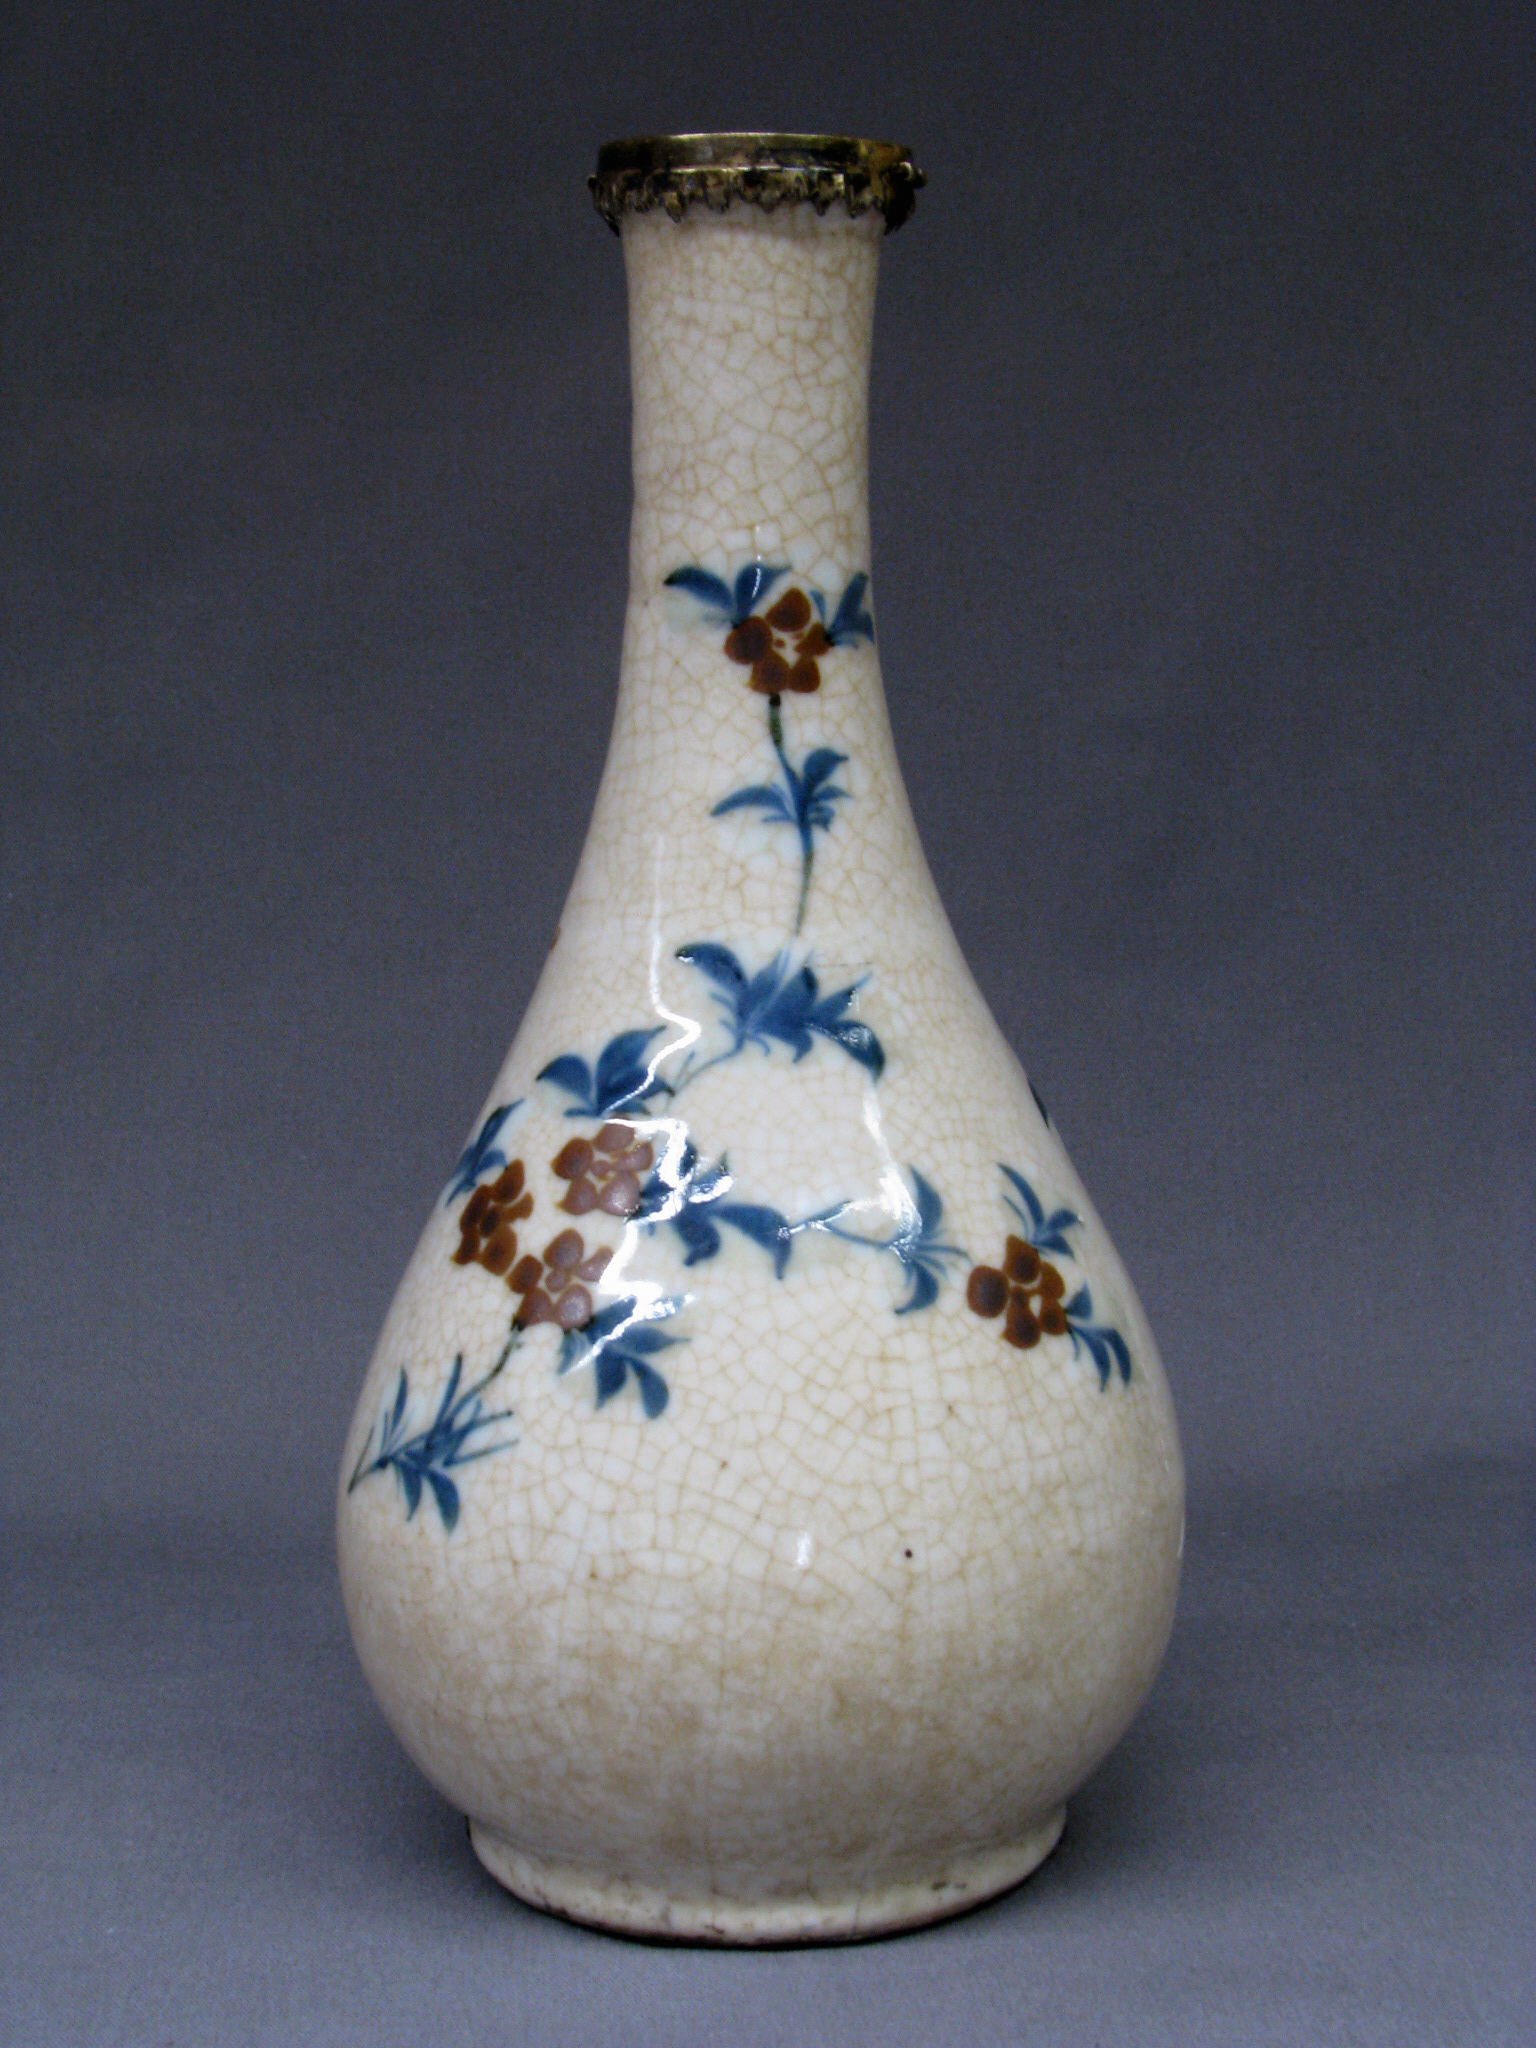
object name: vase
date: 1751-1775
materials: pottery, silver gilt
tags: flowers